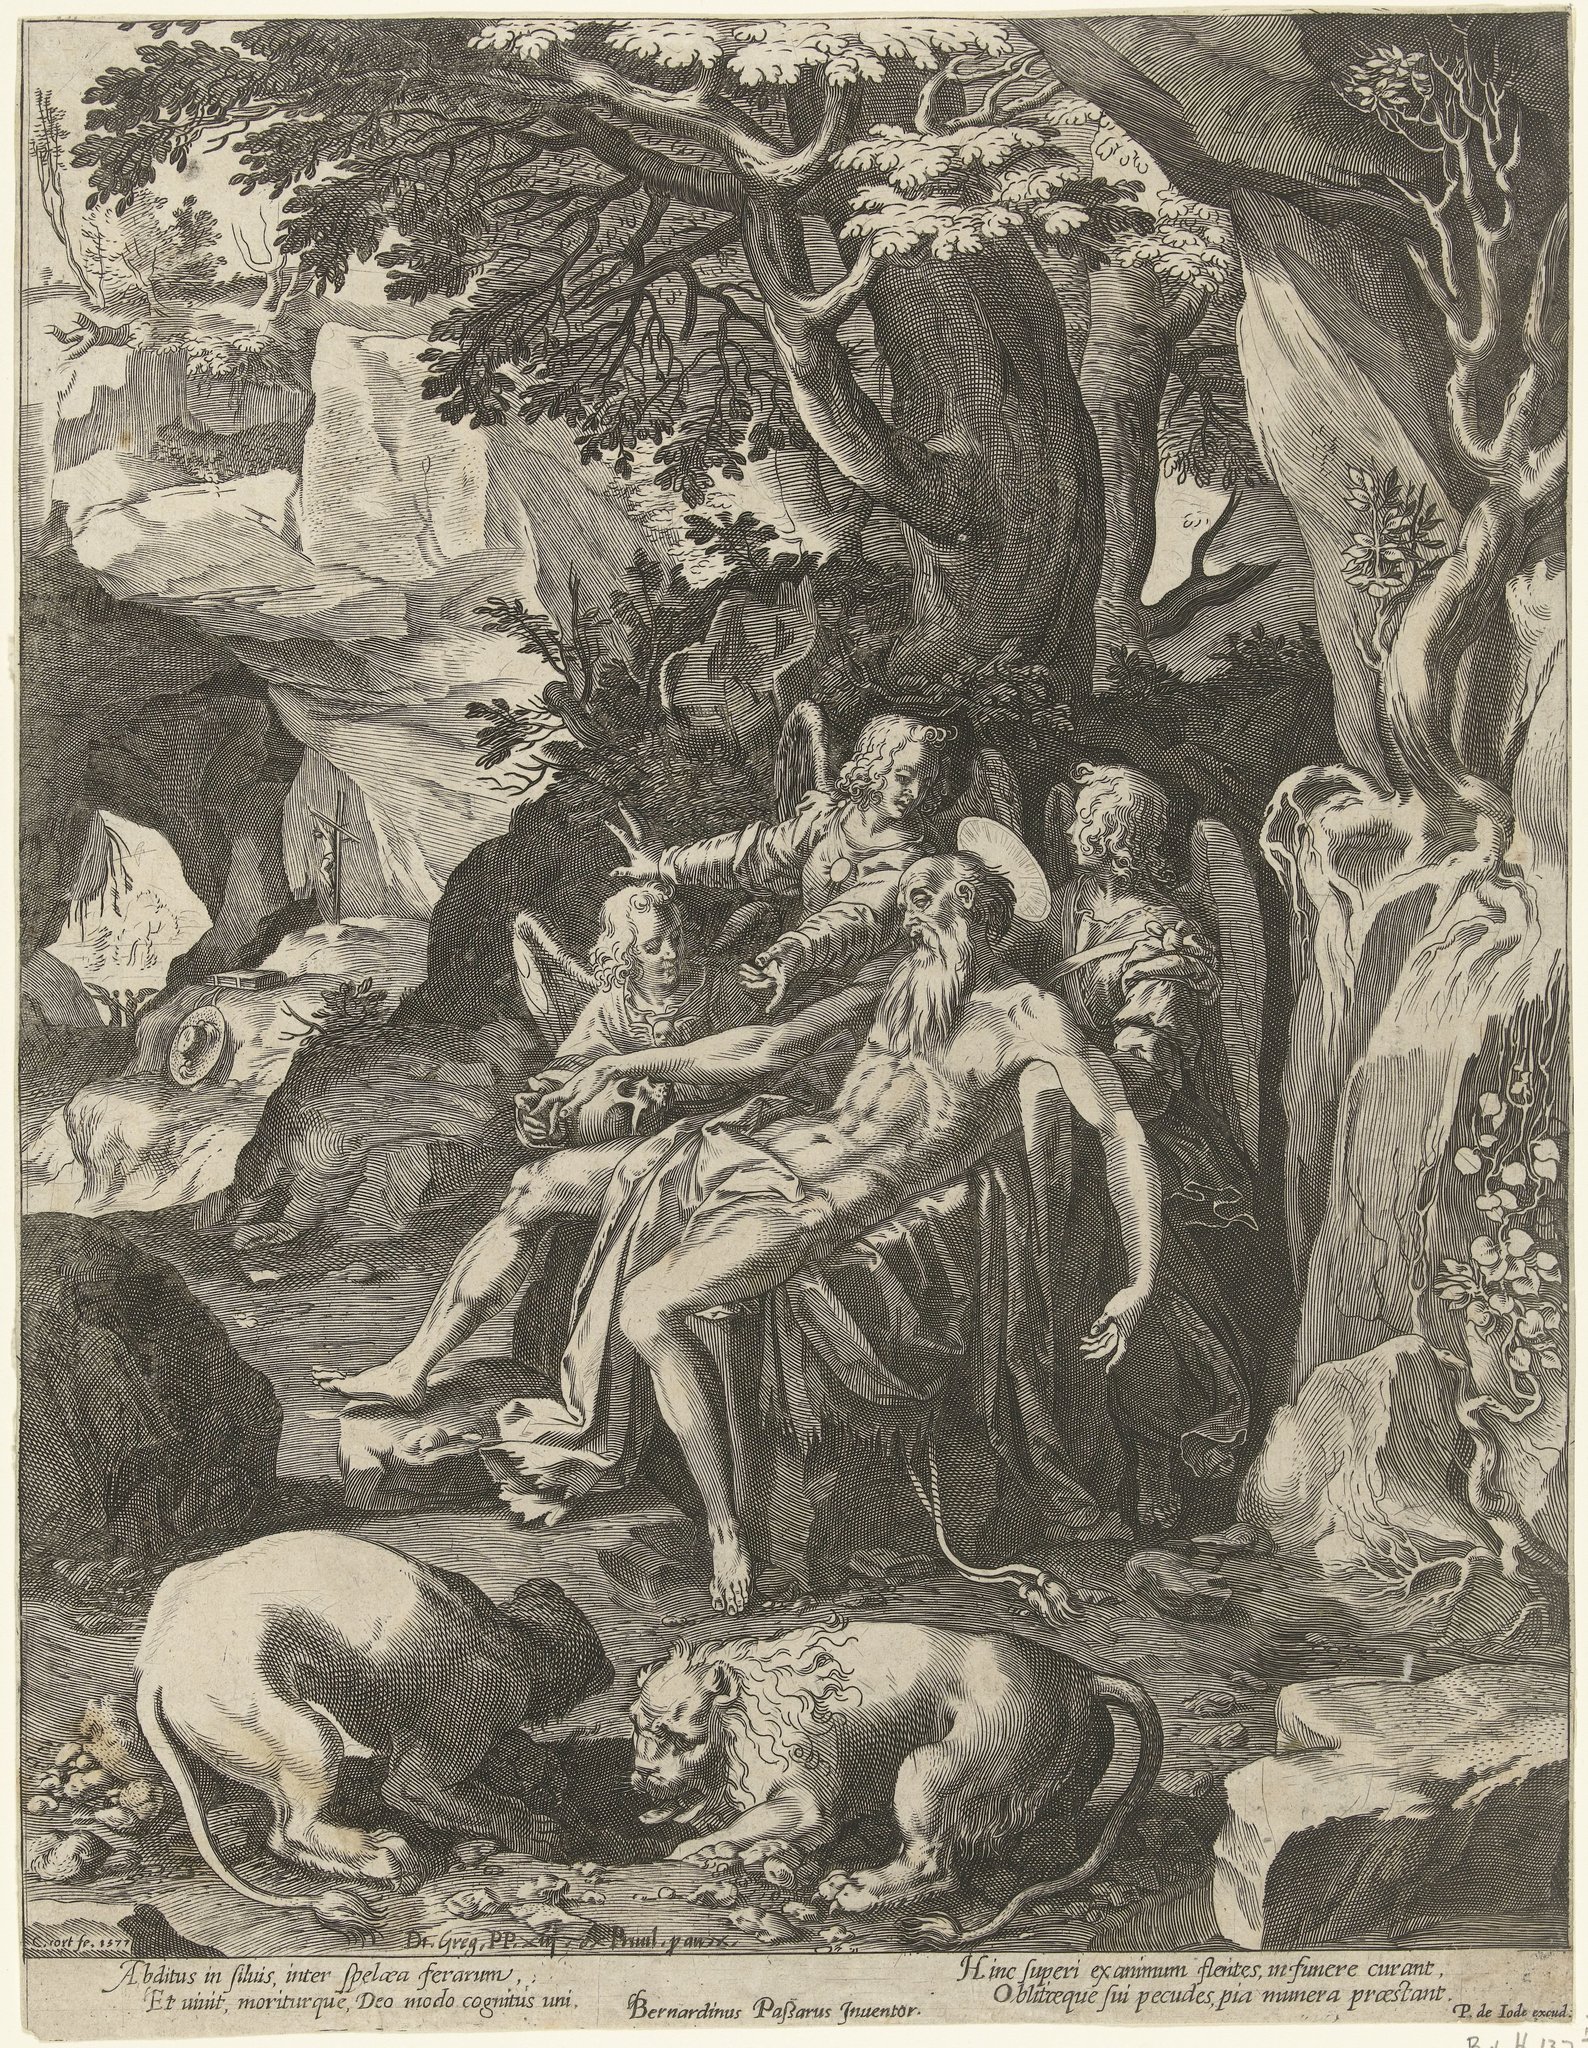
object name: print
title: De H. Hieronymus gedragen door drie engelen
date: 1577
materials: paper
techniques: engraving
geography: rome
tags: the monk and hermit jerome (hieronymus); possible attributes: book, cardinal's hat, crucifix, hour-glass, lion, skull, stone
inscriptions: collector's mark: Lugt 240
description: Drie engelen leggen het lichaam van de dode Hieronymus op een steen. Op de achtergrond is de grot te zien waar Hieronymus als kluizenaar leefde. Twee leeuwen graven een kuil bij wijze van graf.